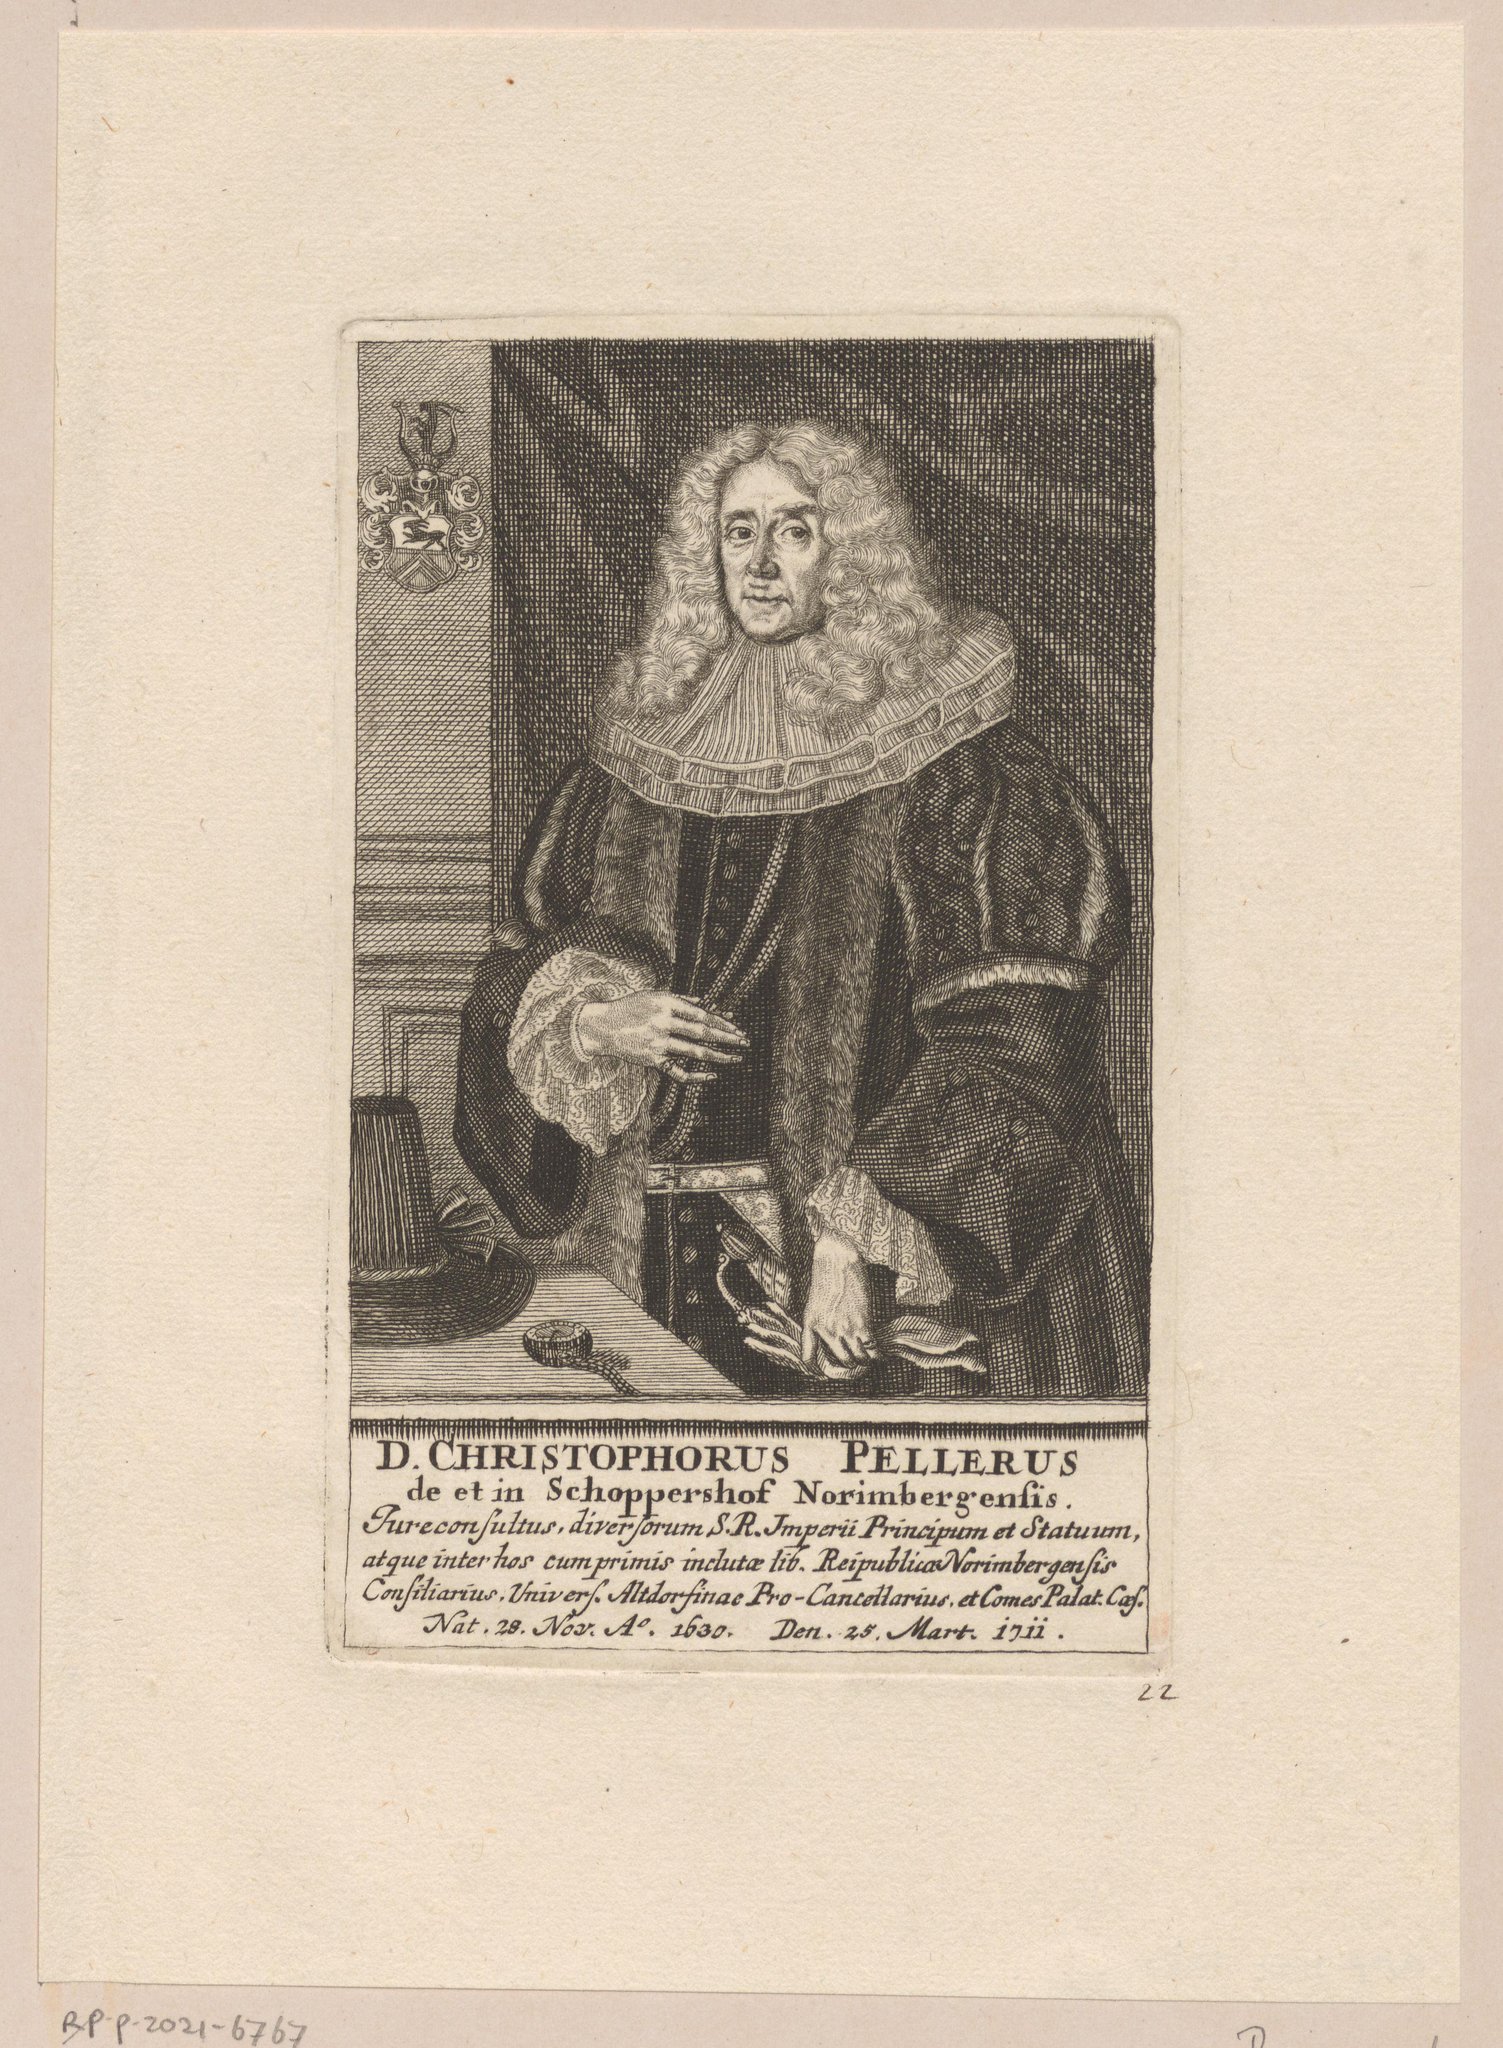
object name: print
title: Portret van Christoph Peller von Schoppershof II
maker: Anonymous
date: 1711-1721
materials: paper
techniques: engraving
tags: adult man, historical persons, armorial bearing, heraldry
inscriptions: inscription: ‘22’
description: Latere staat gebruikt in: Apin, Siegmund Jacob. Vitae et effigies Procancellariorum Academiae Altorfinae. Neurenberg en Altdorf: erven Johann Daniel Taubers, 1721.